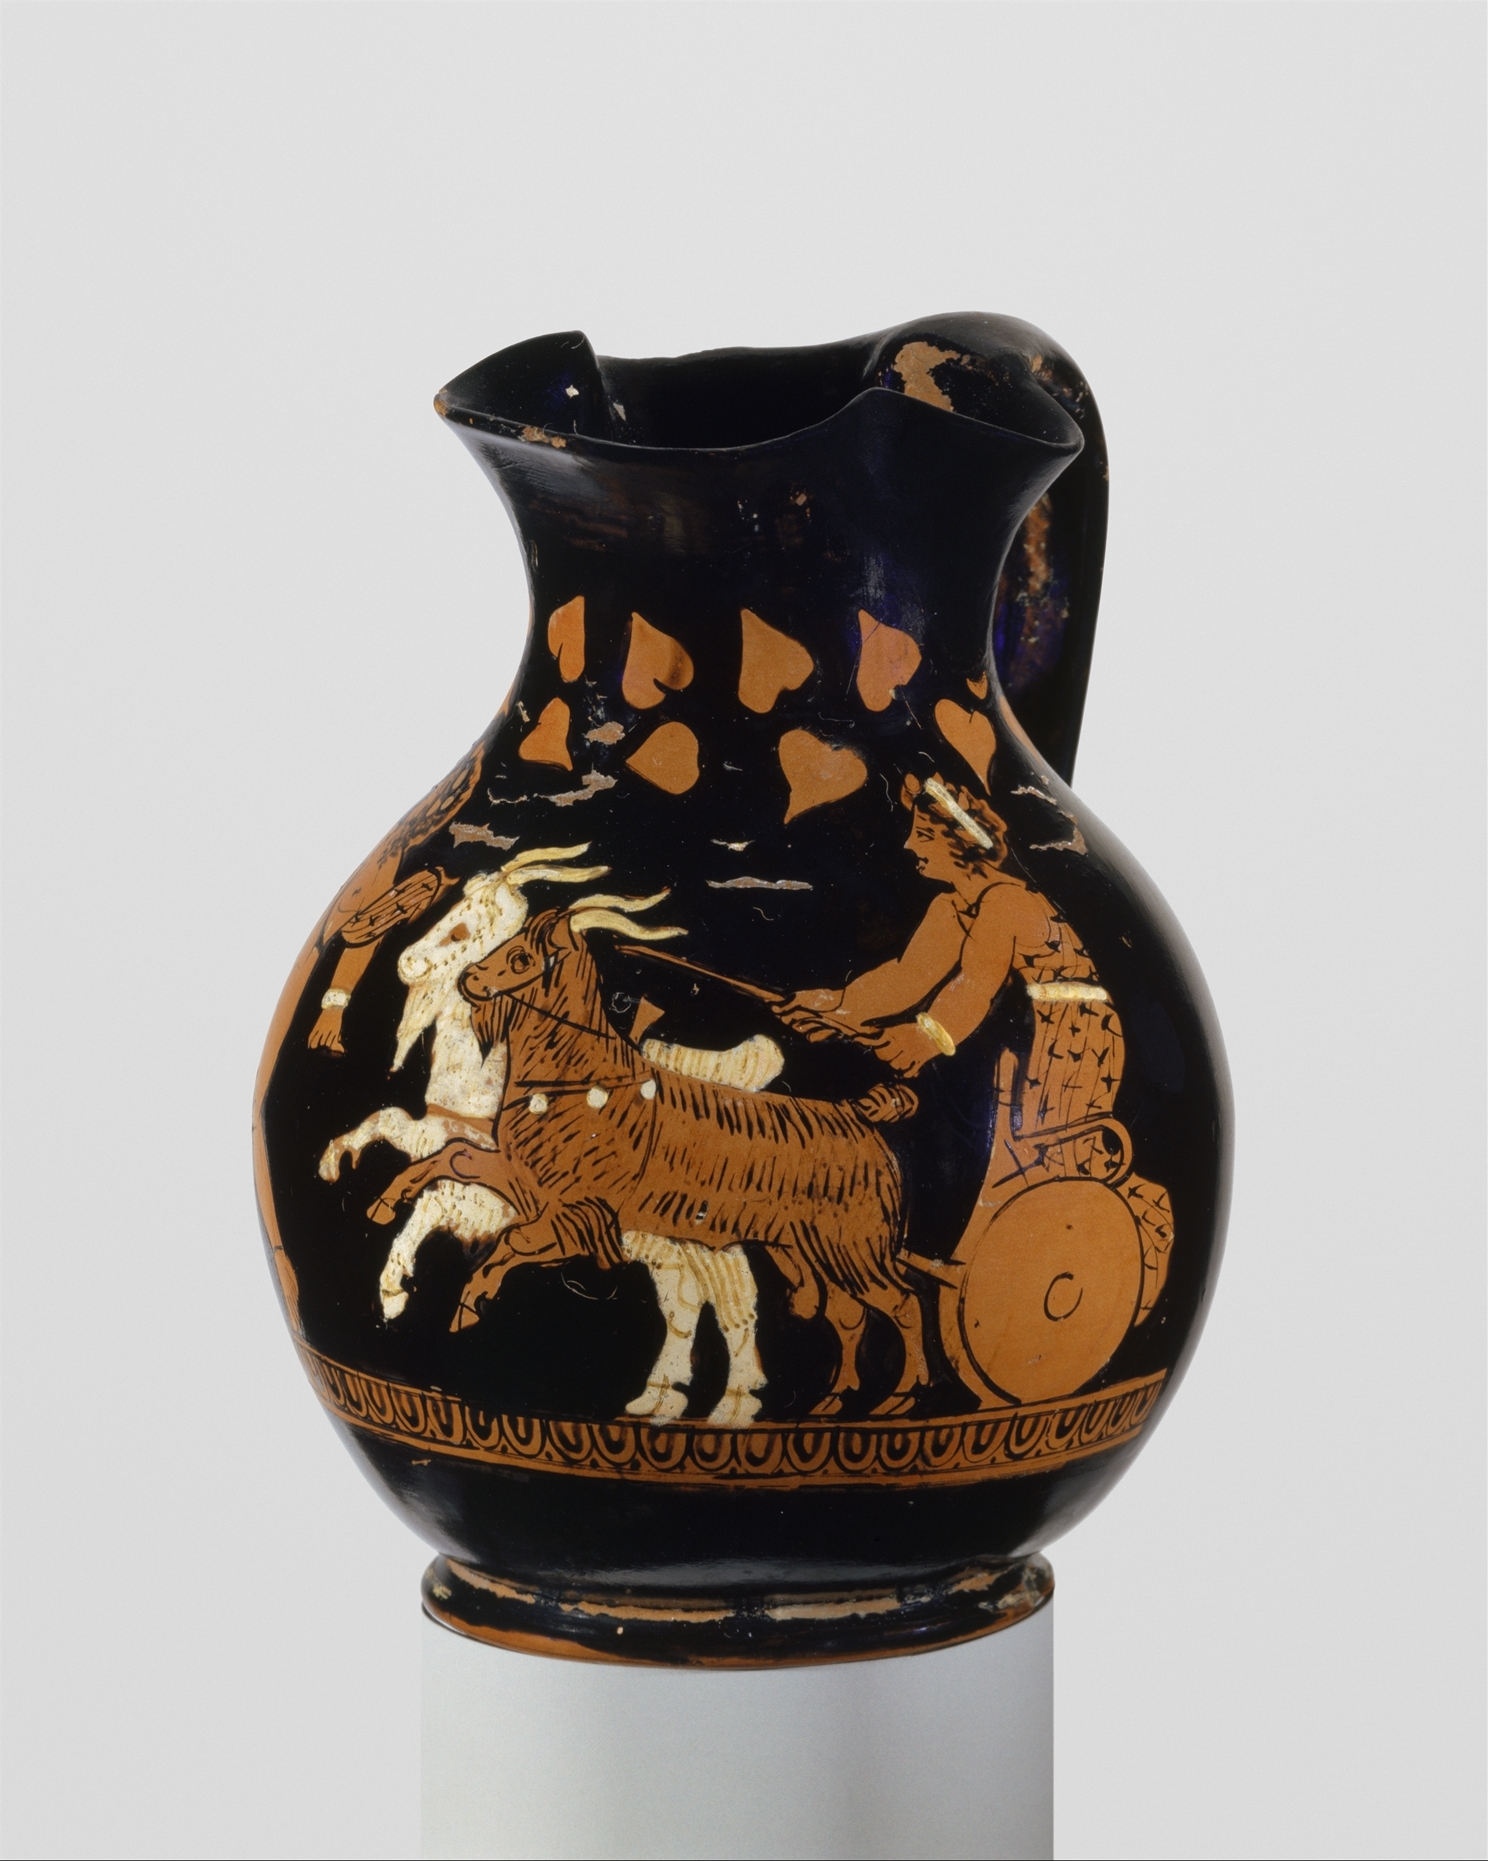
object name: oinochoe, miniature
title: Terracotta oinochoe: chous (jug)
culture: greek, attic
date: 400 BCE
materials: terracotta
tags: boys,goats,chariots